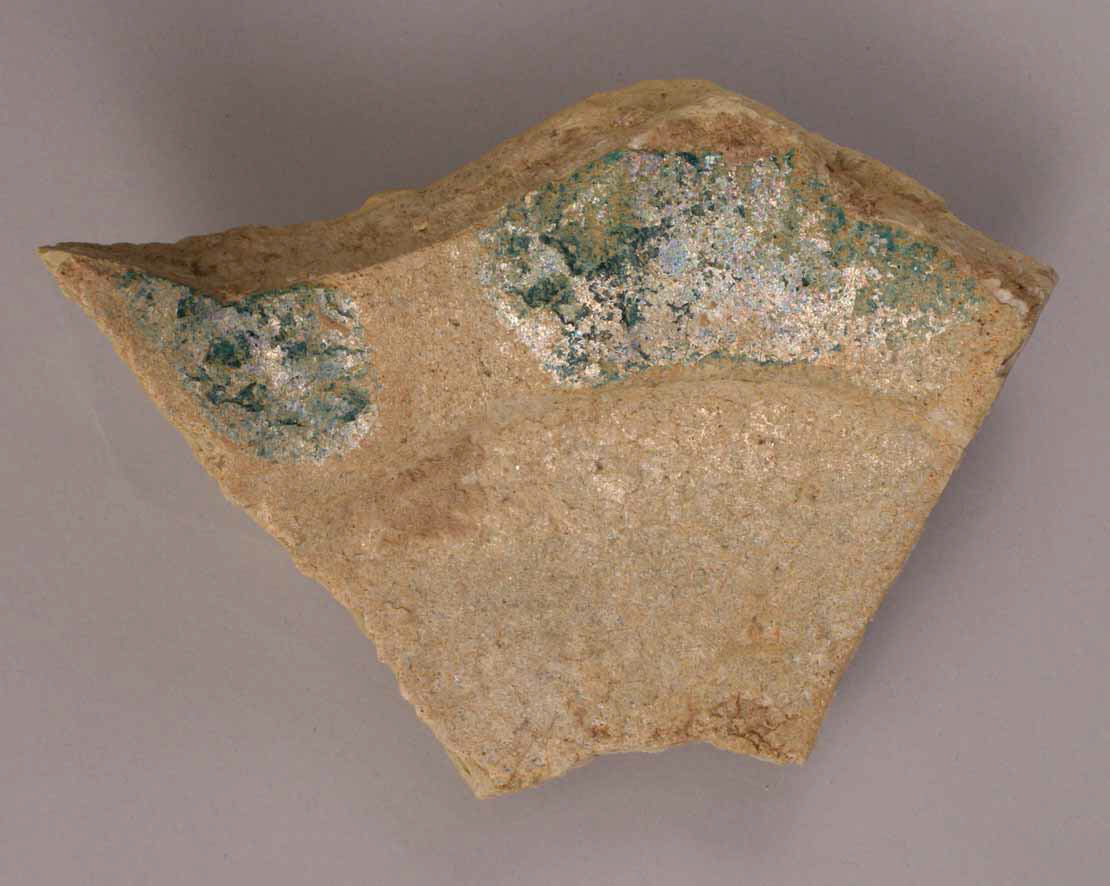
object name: fragment of a bowl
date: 801-900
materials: earthenware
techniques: glazing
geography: iraq